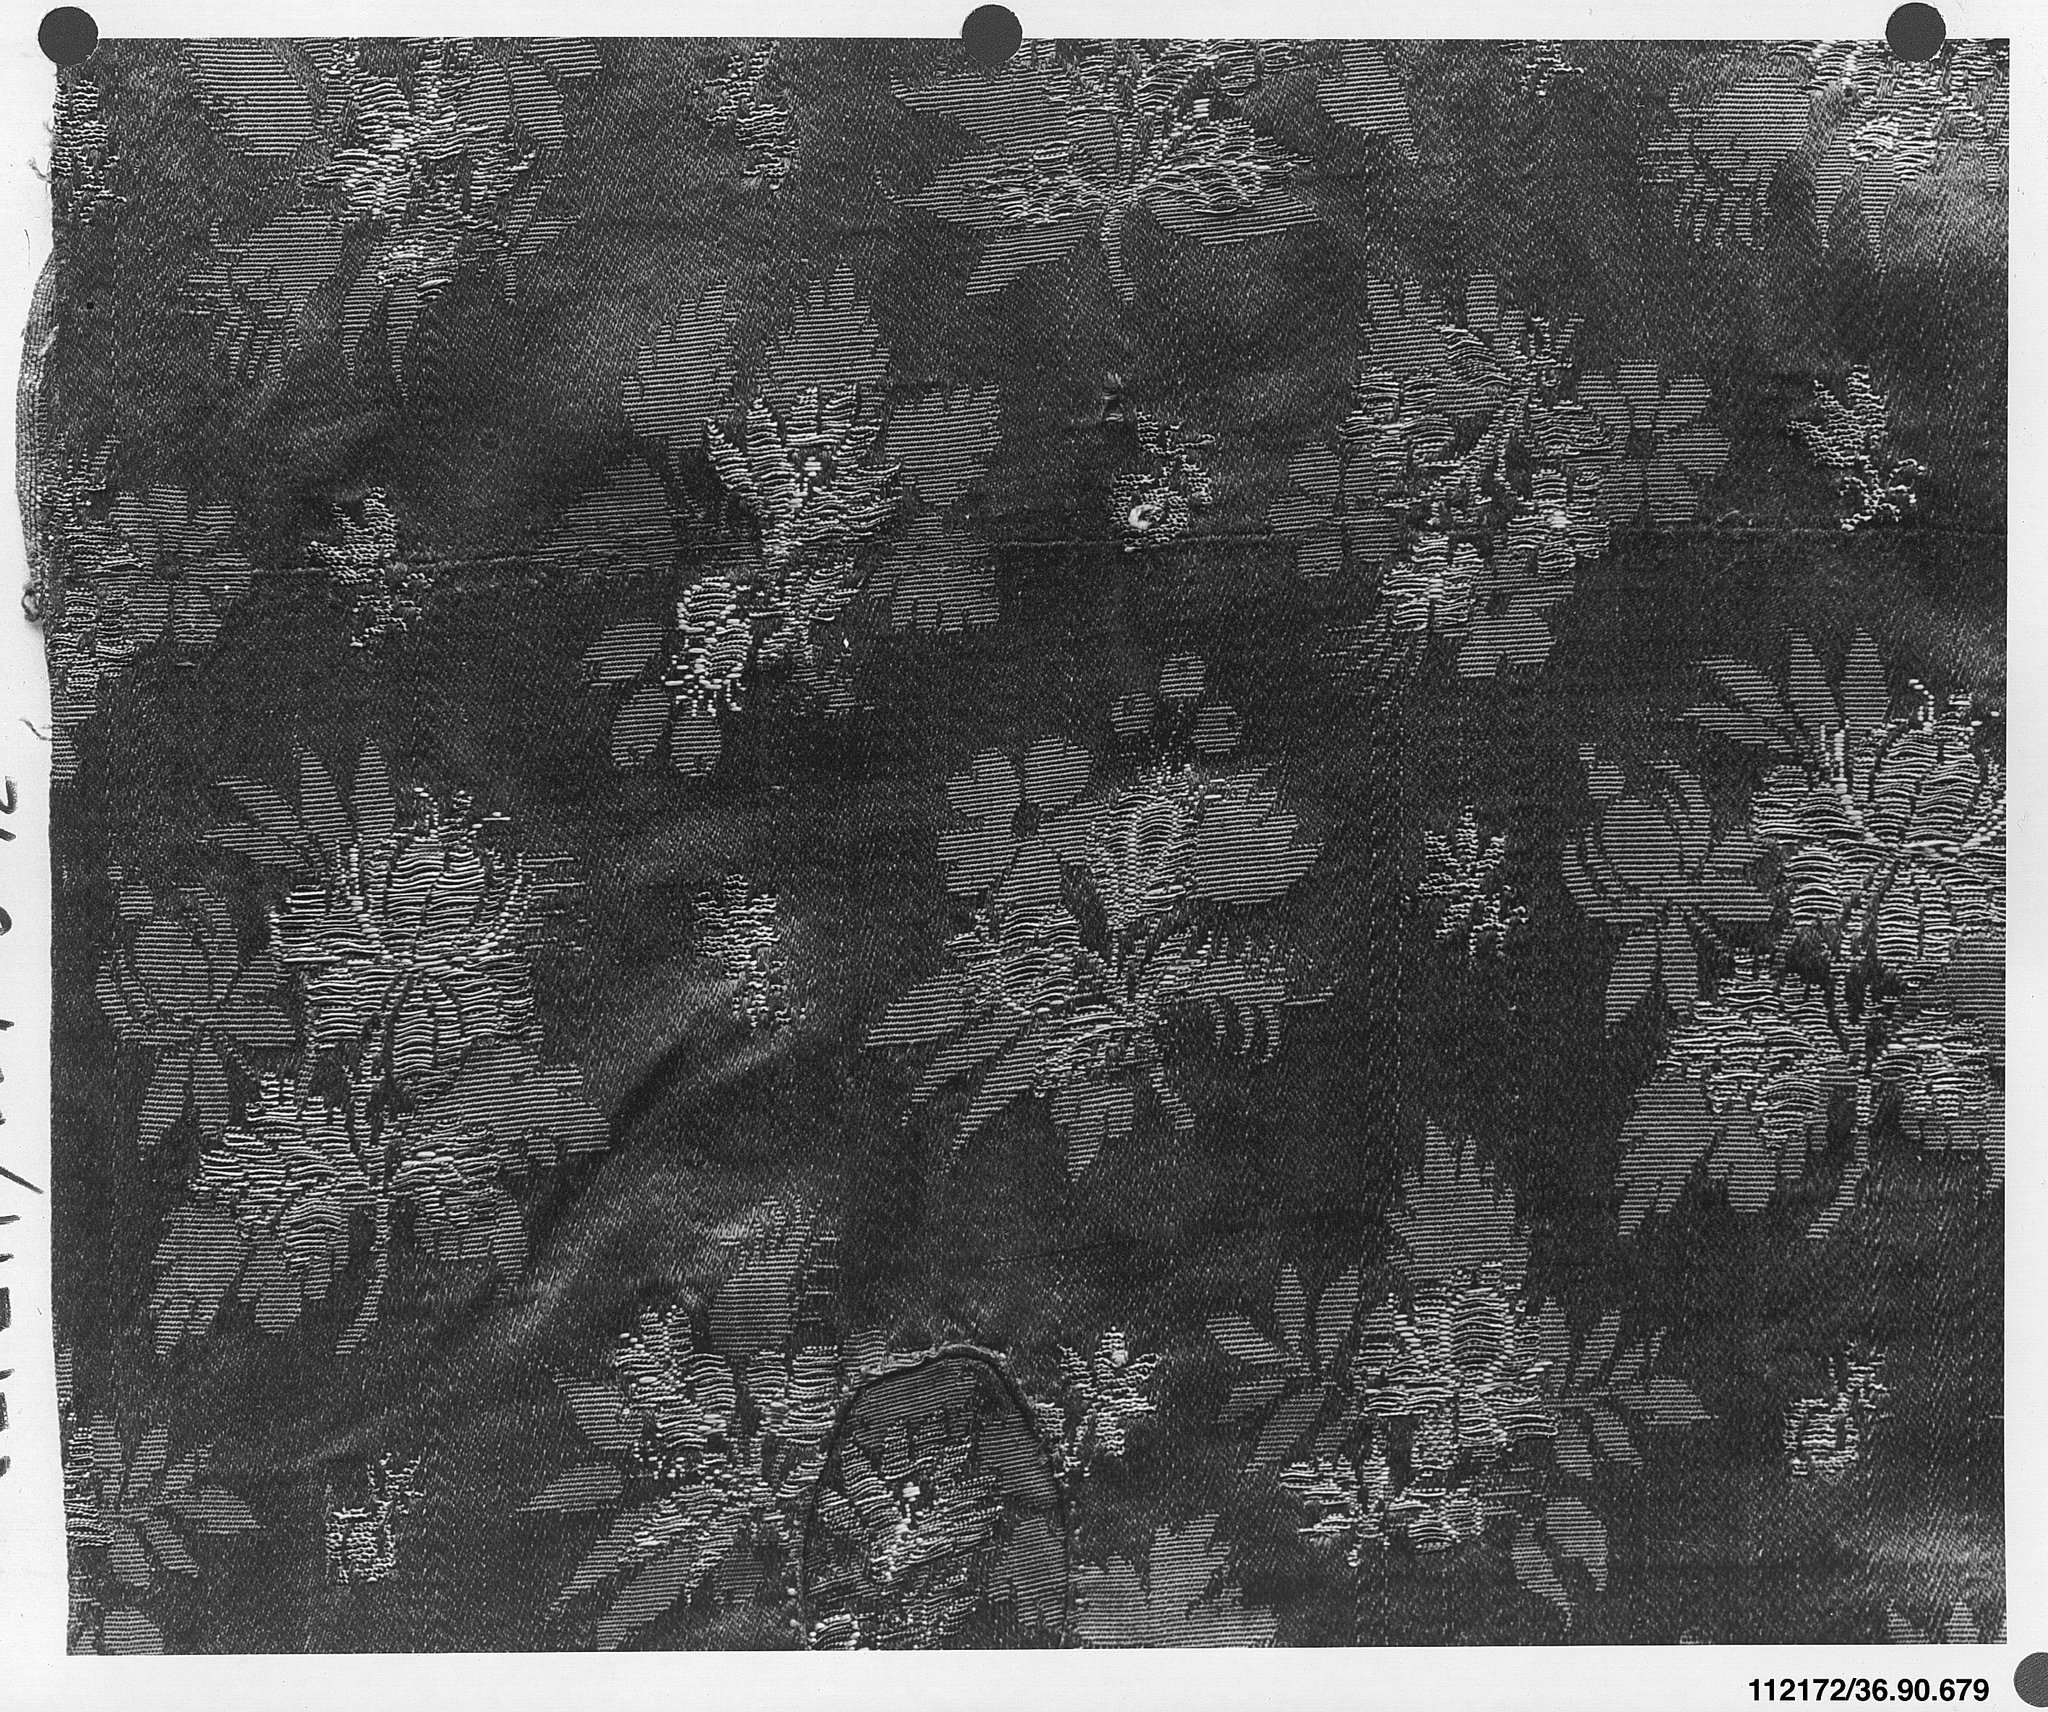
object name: piece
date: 1695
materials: silk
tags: flowers,leaves